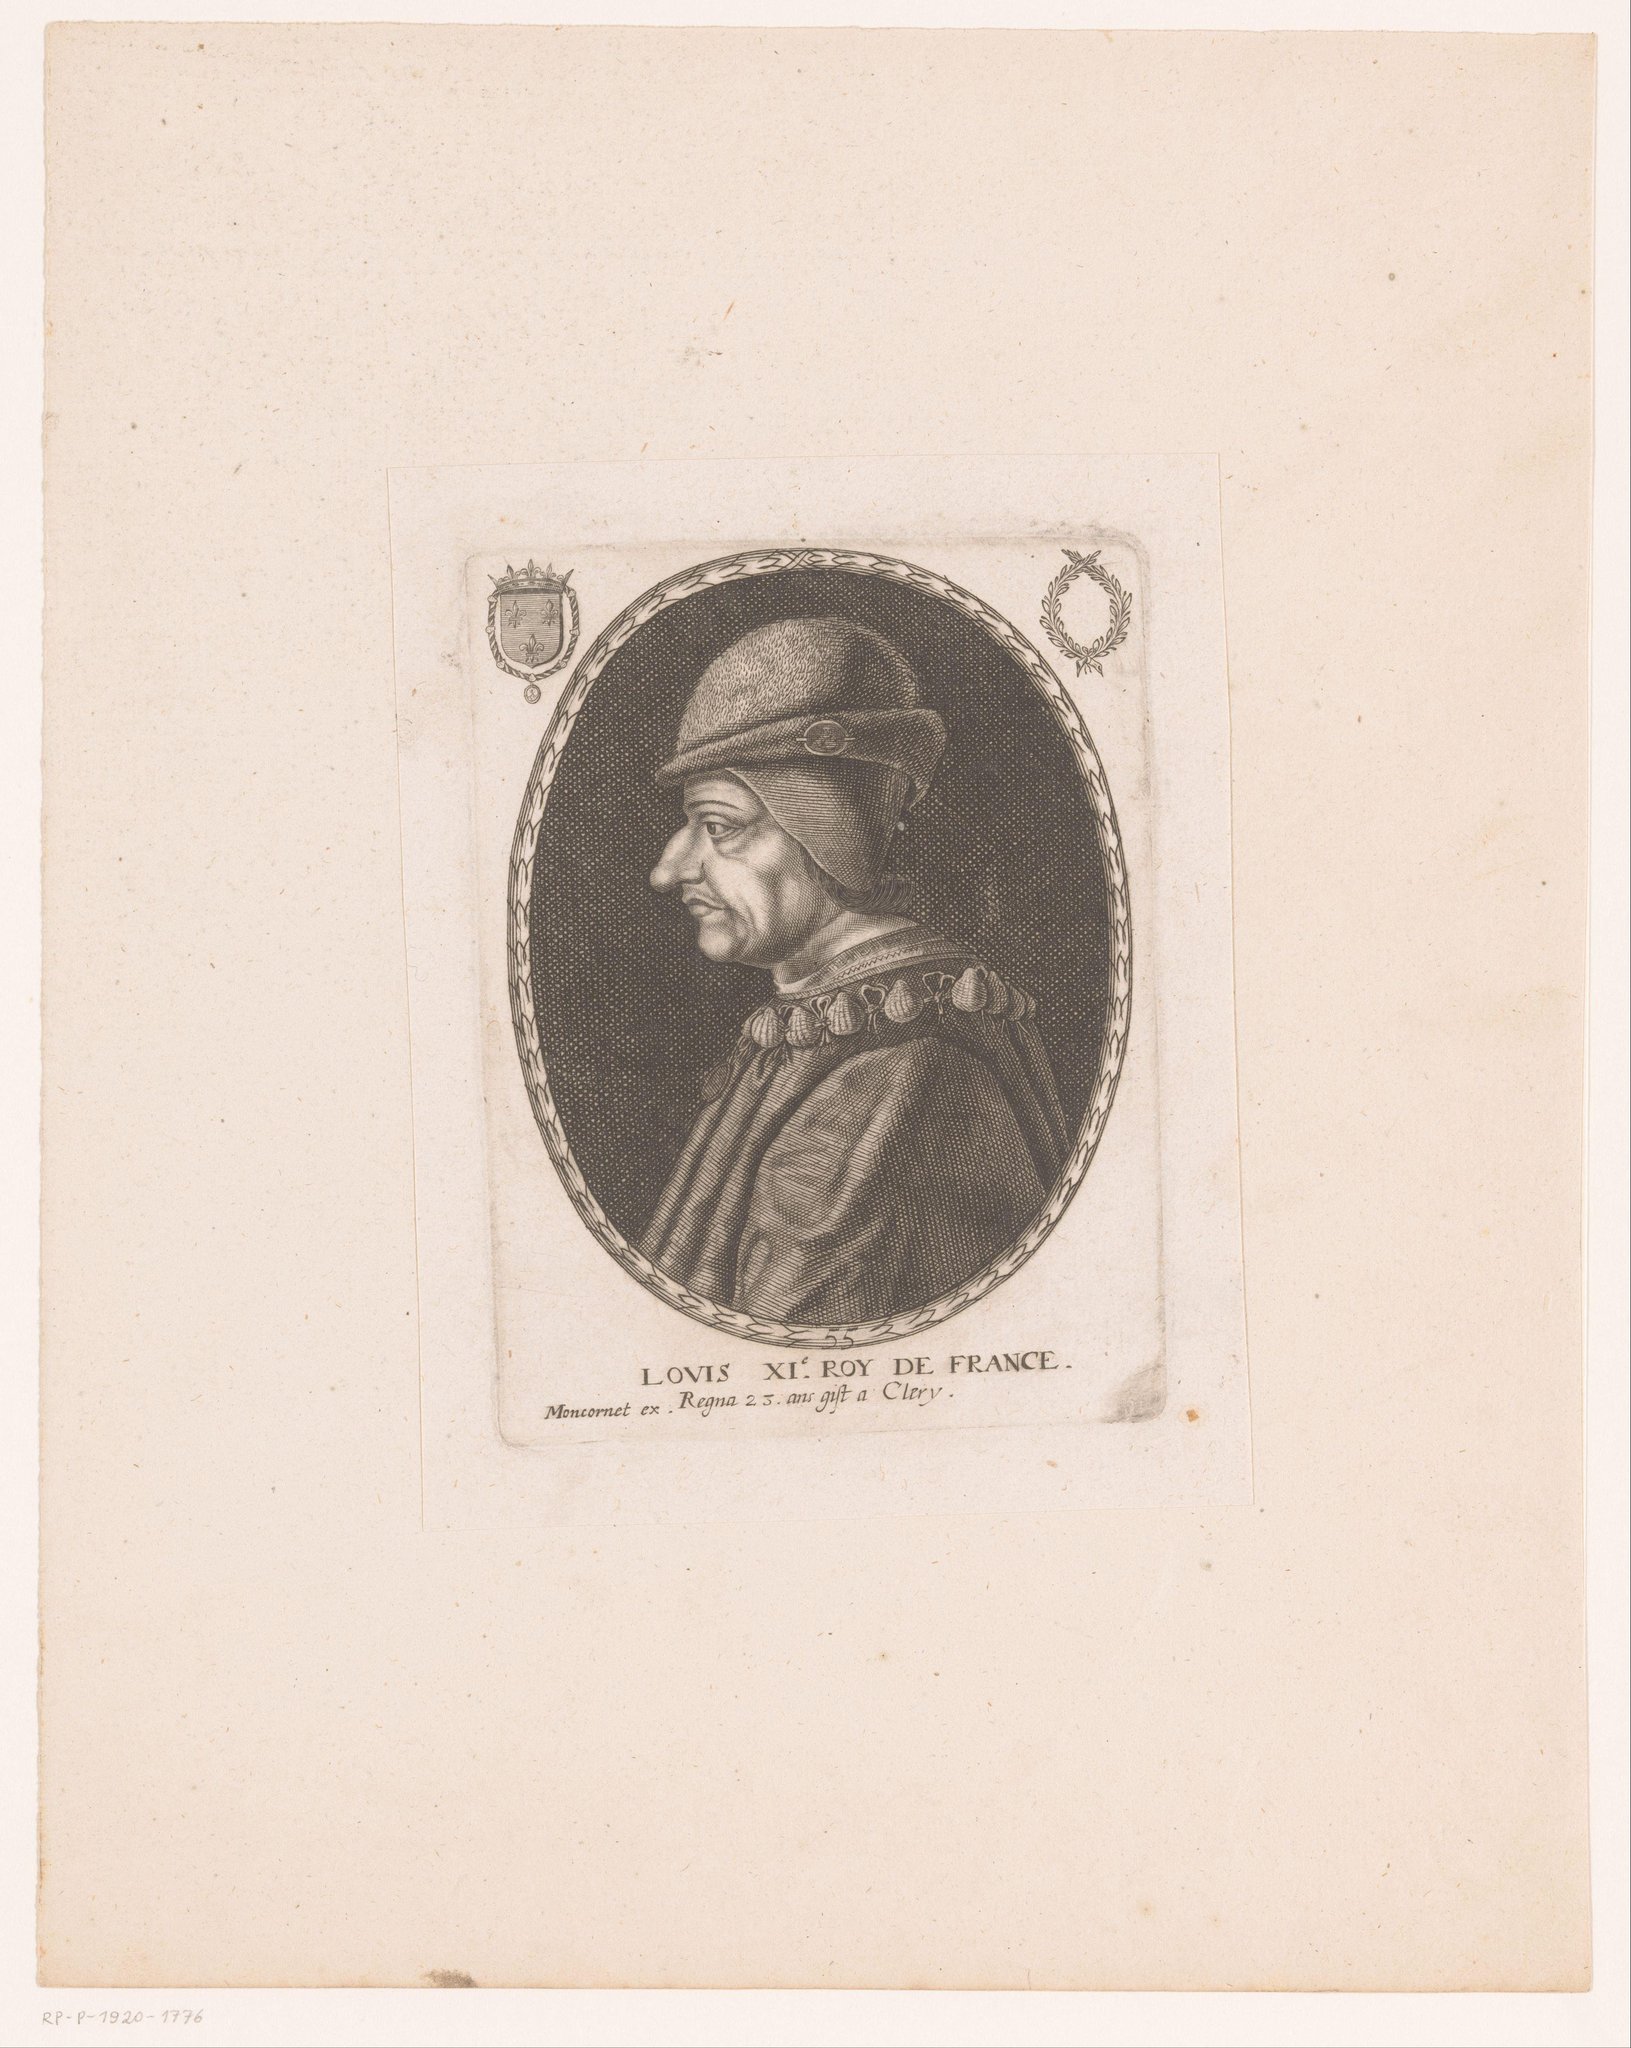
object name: print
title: Portret van Lodewijk XI van Frankrijk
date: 1610-1668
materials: paper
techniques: engraving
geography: paris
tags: historical persons, king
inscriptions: collector's mark: Lugt 2228